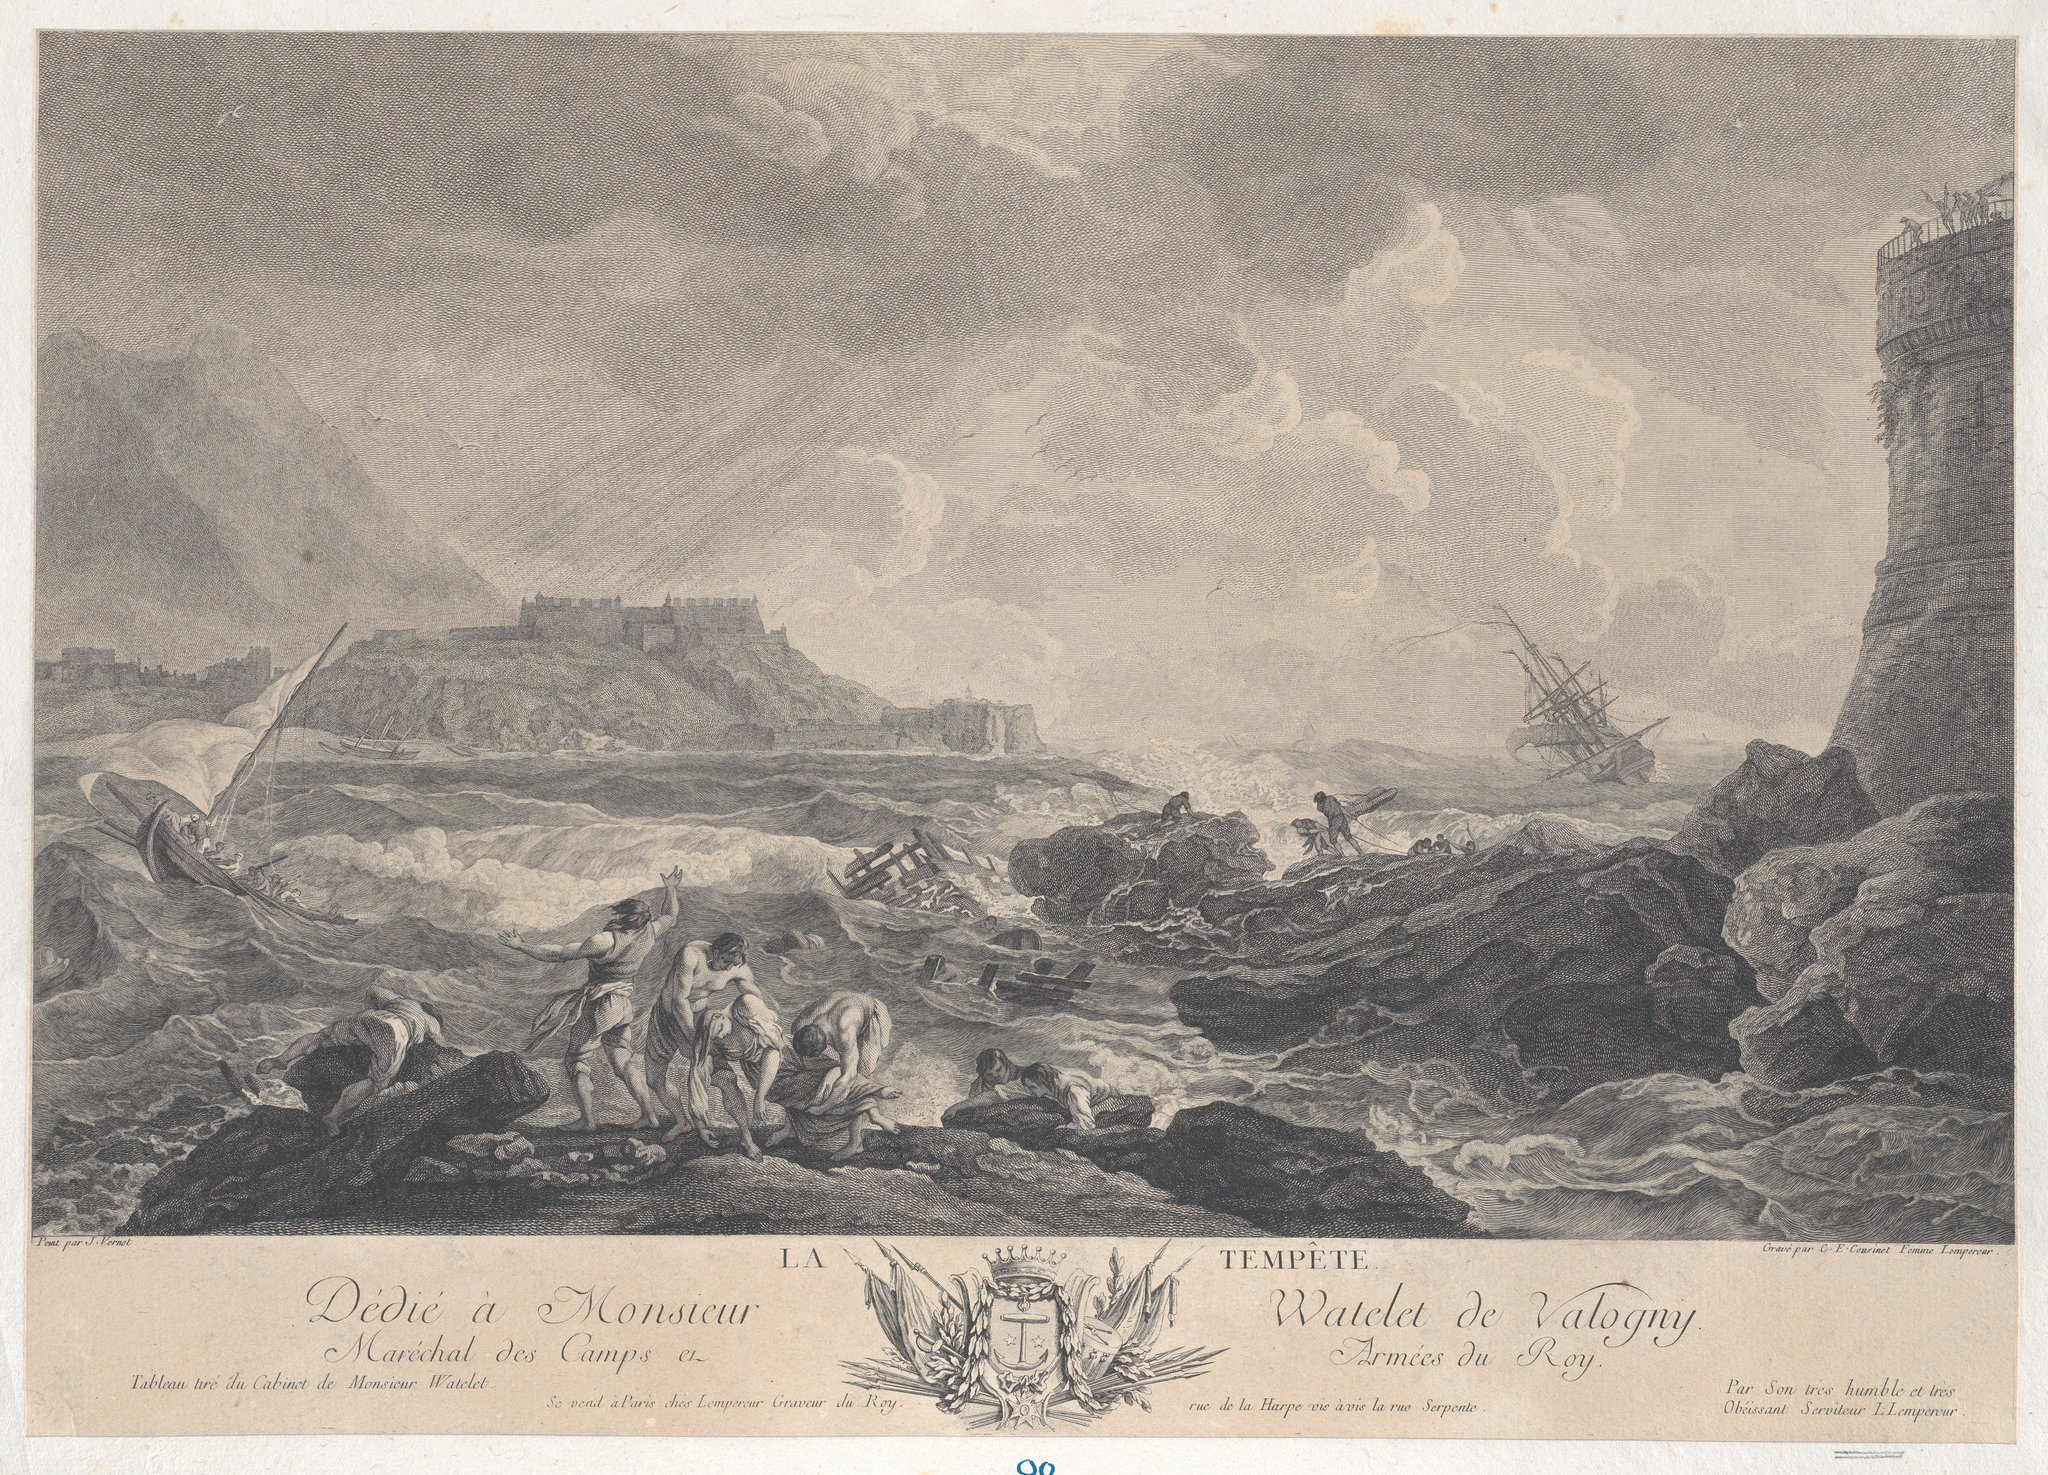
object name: print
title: The Storm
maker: joseph vernet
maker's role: artist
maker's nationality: french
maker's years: 1714-1789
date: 1750-1800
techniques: engraving